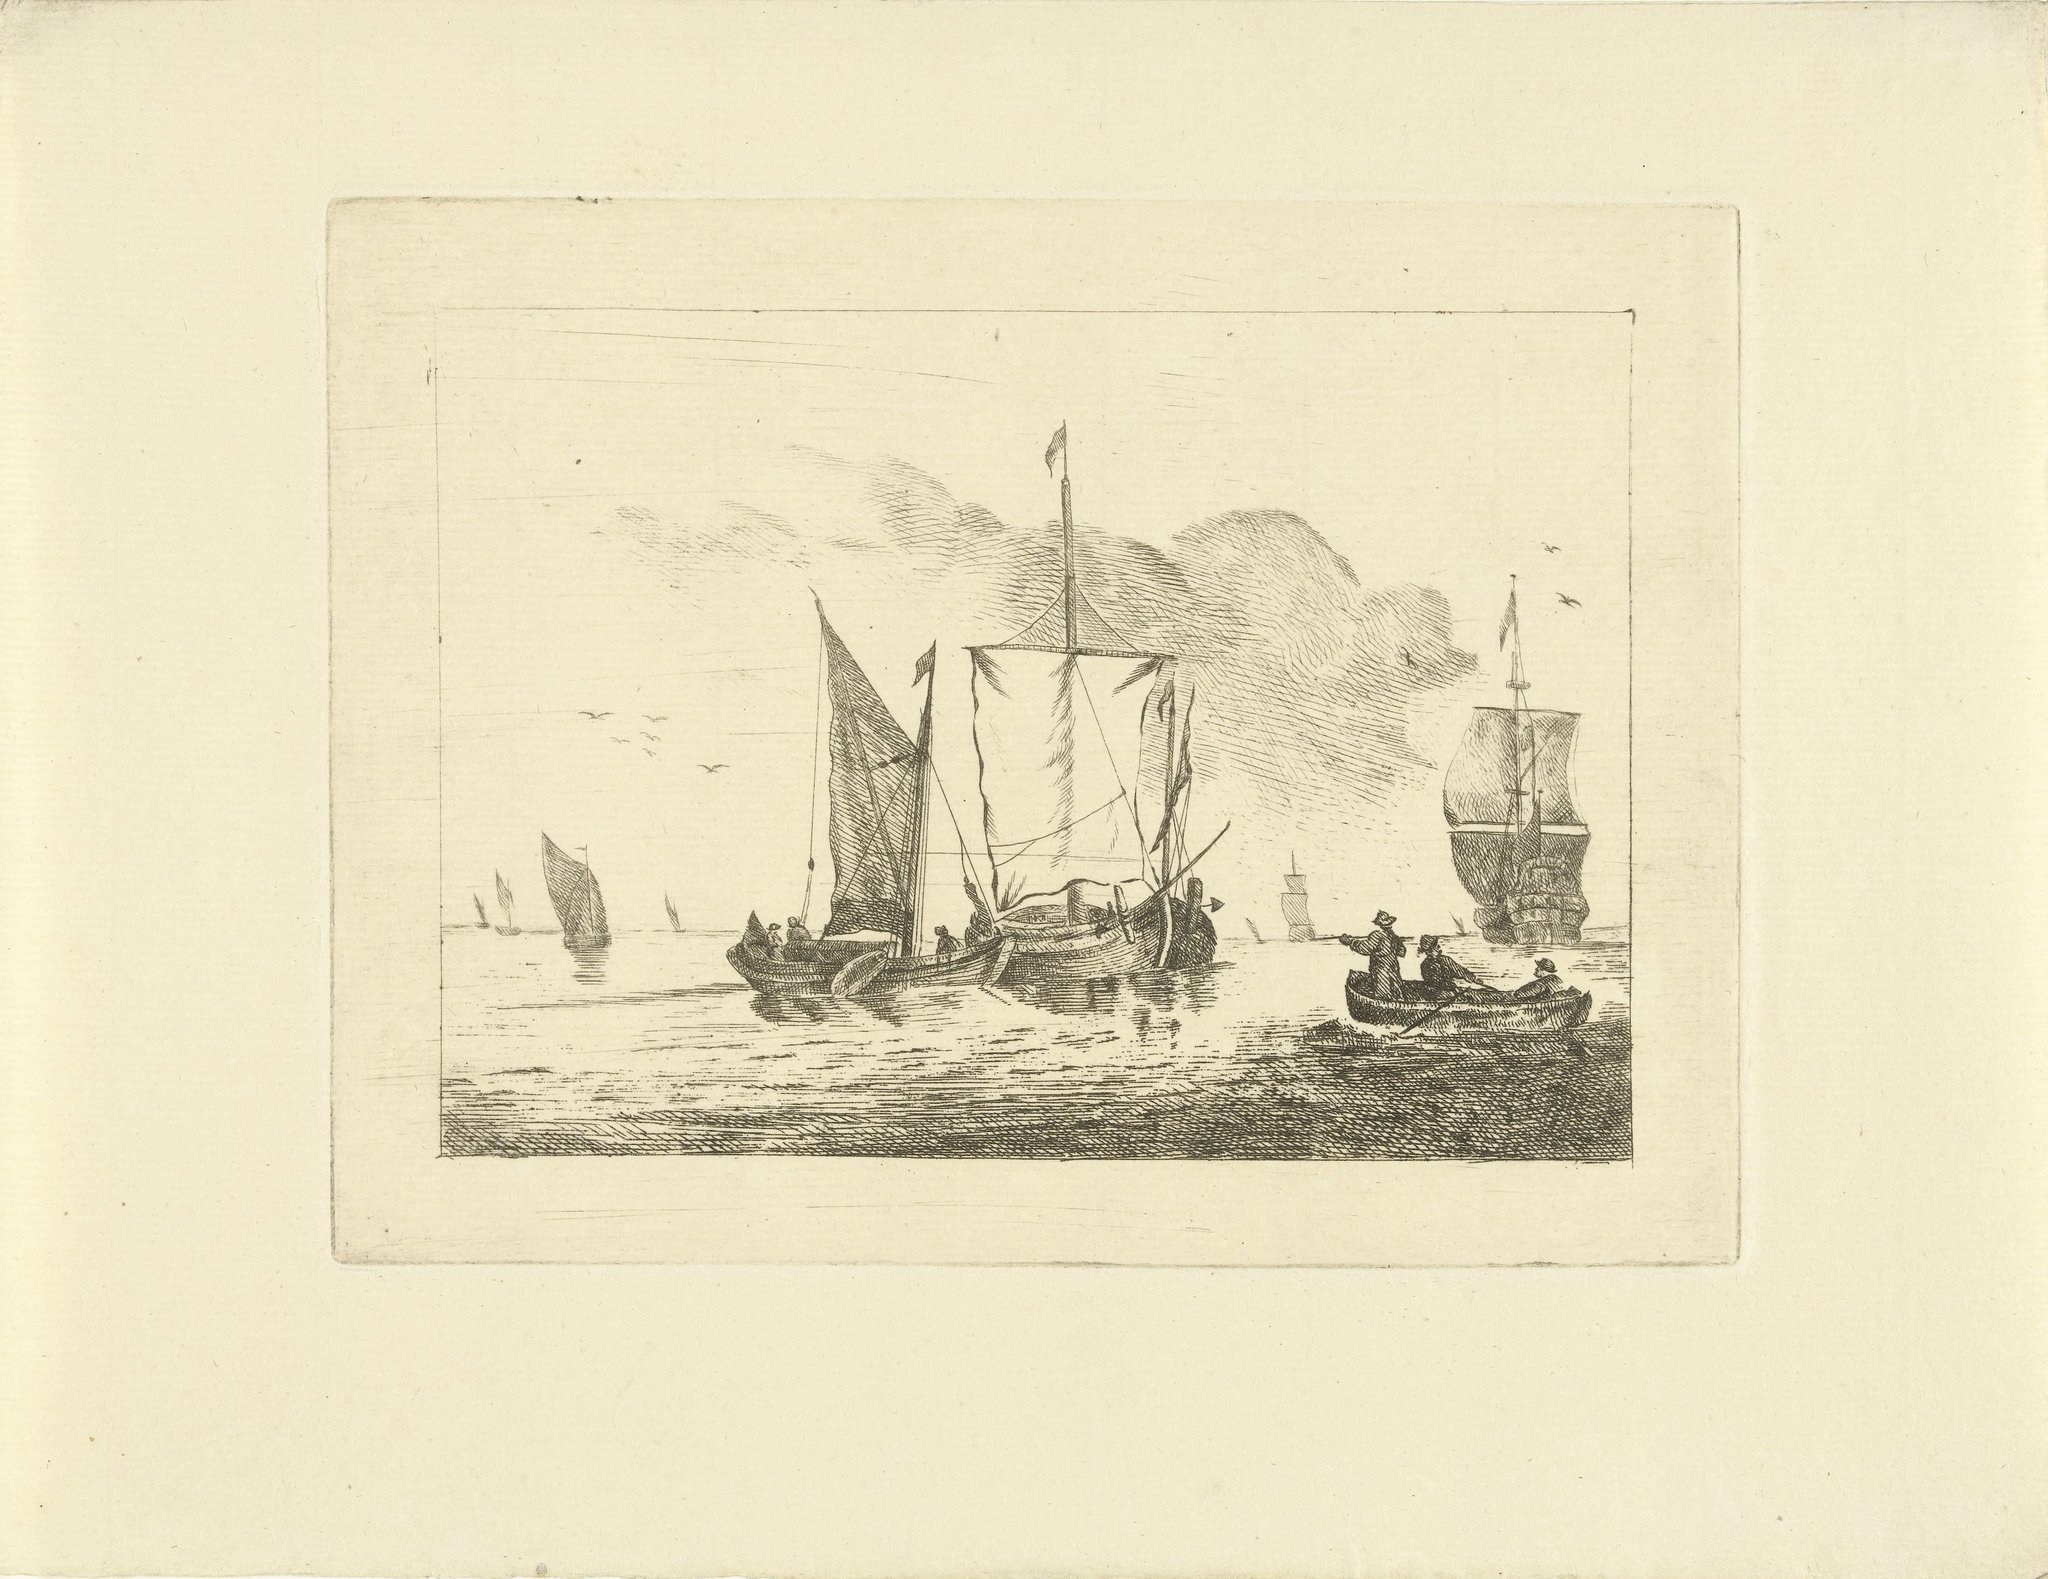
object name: print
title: Zeilschepen op zee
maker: g. van citters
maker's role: print maker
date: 1750-1800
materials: paper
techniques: etching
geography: netherlands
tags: sailing-ship, sailing-boat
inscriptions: collector's mark: Lugt 2233